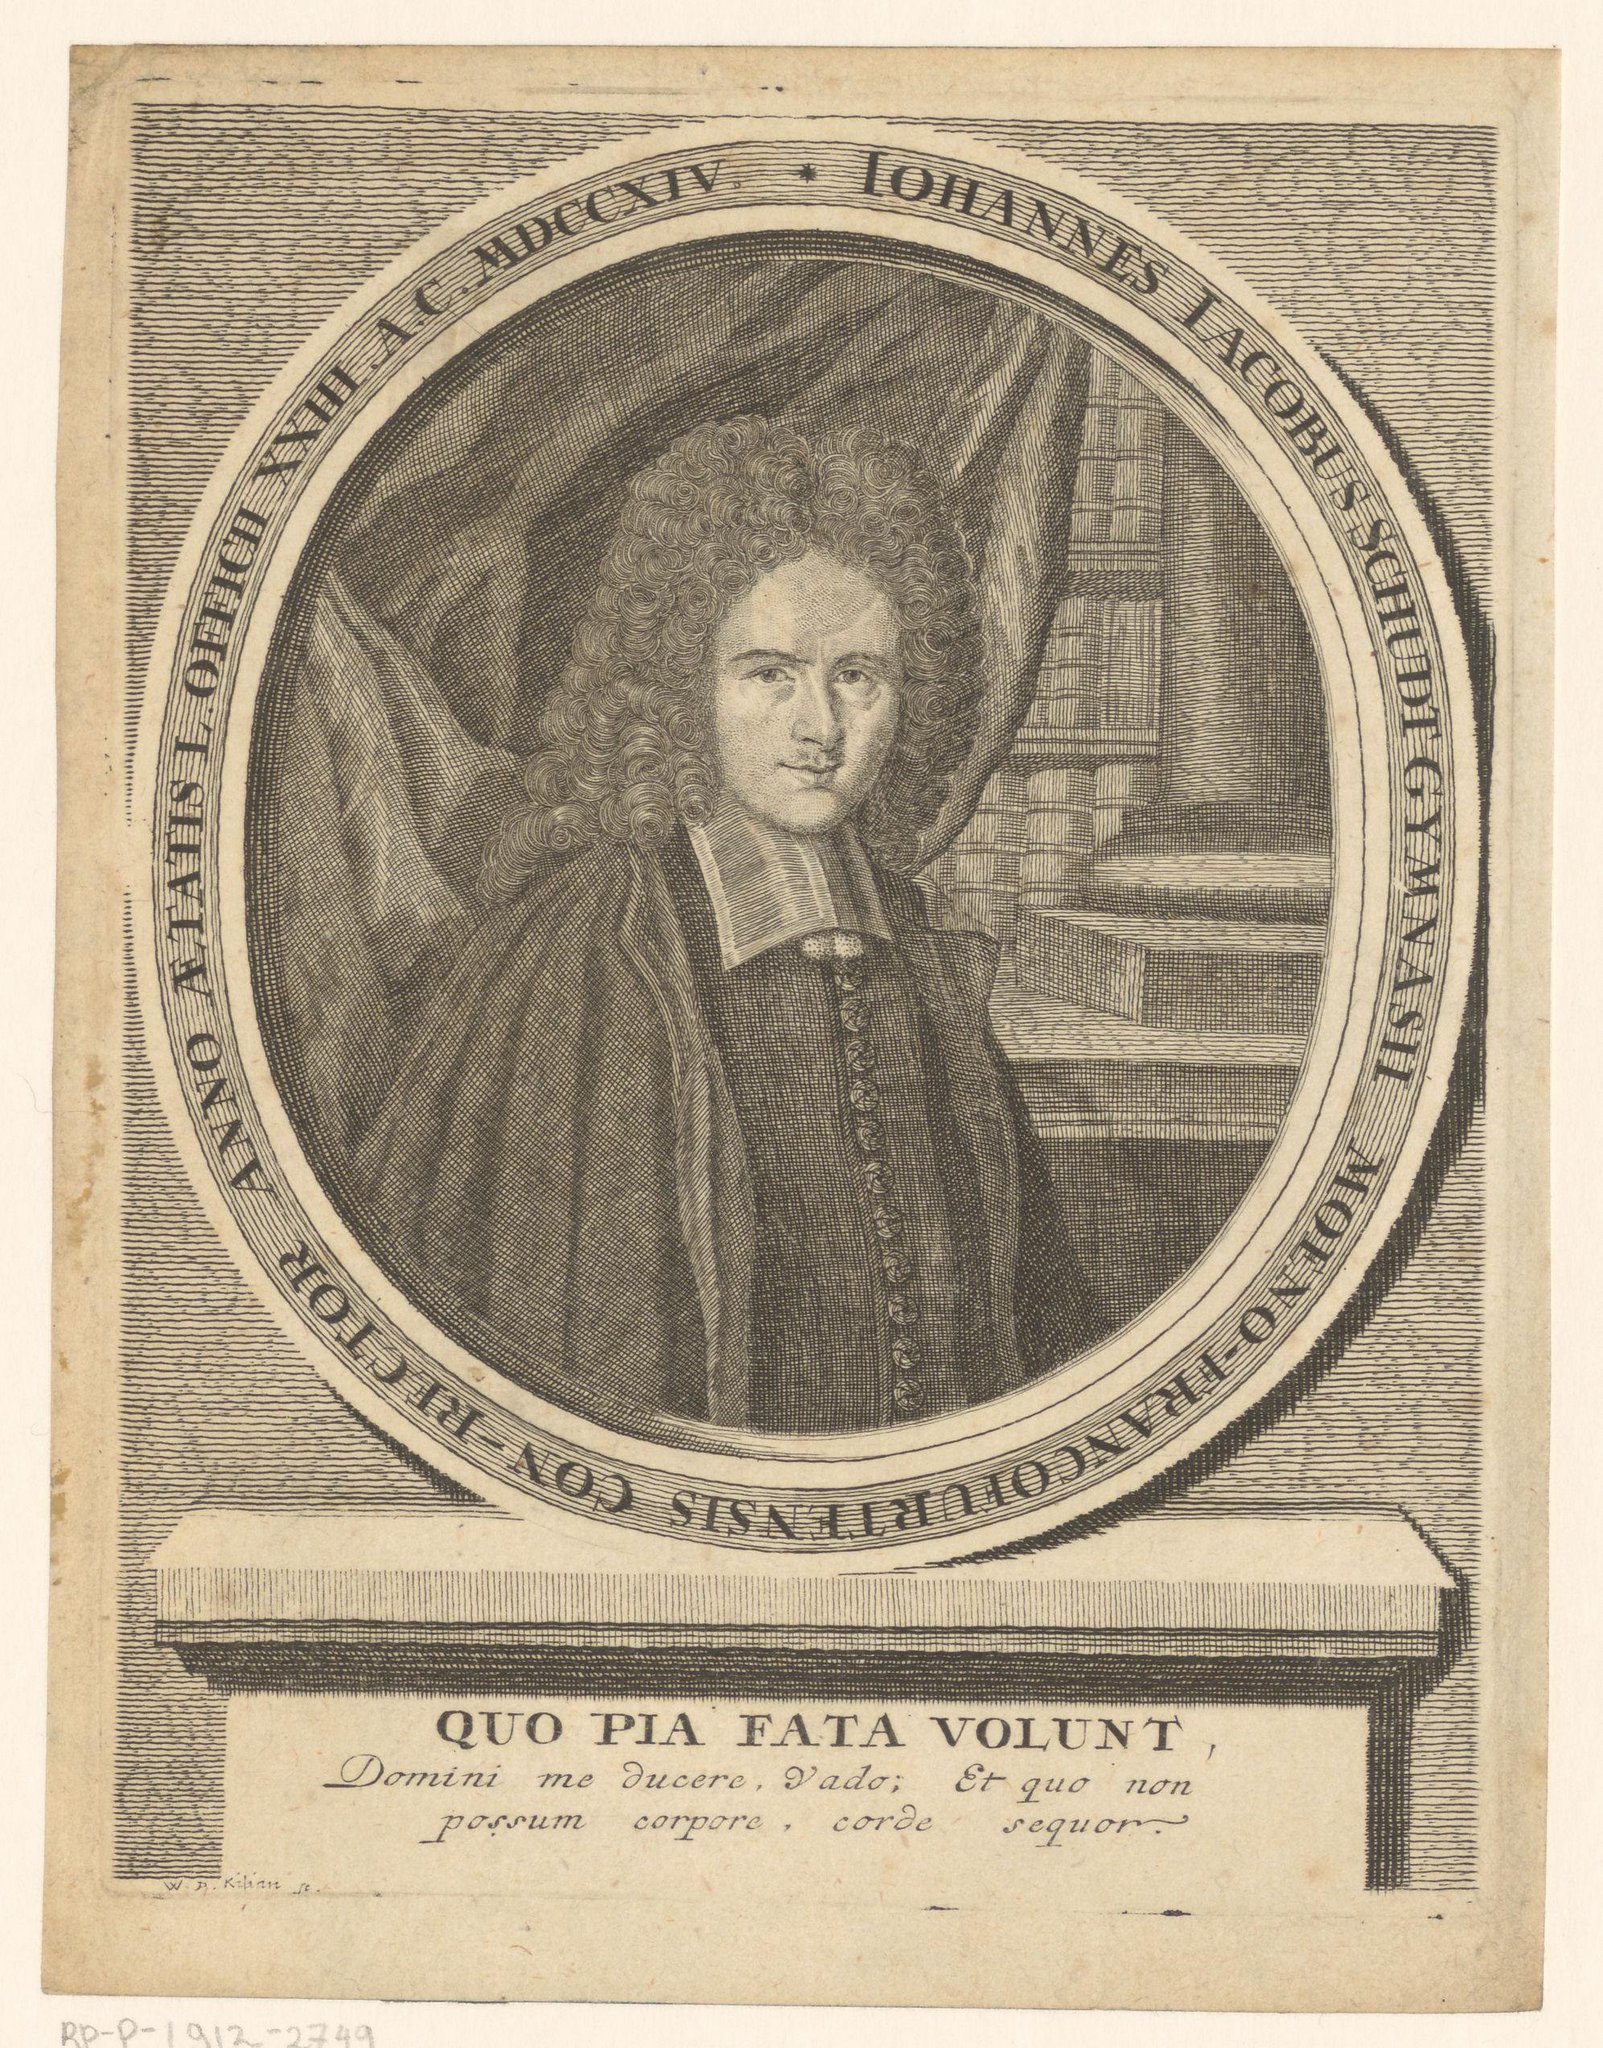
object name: print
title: Portret van Johann Jacob Schudt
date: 1714-1722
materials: paper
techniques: engraving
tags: further education (+ portrait of teacher, professor), ethnology, cultural anthropology (+ portrait of scholar, scientist), historical persons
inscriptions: collector's mark: Lugt 2228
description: Tekst in het Latijn in de omlijsting en in de ondermarge.